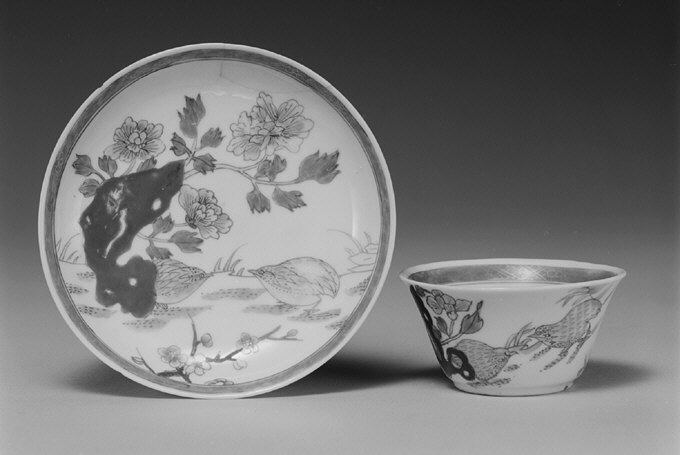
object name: teabowl and saucer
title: Teabowl and saucer with quail and peonies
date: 1710-1730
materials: enamel, glaze, hard paste porcelain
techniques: painting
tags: birds,peonies